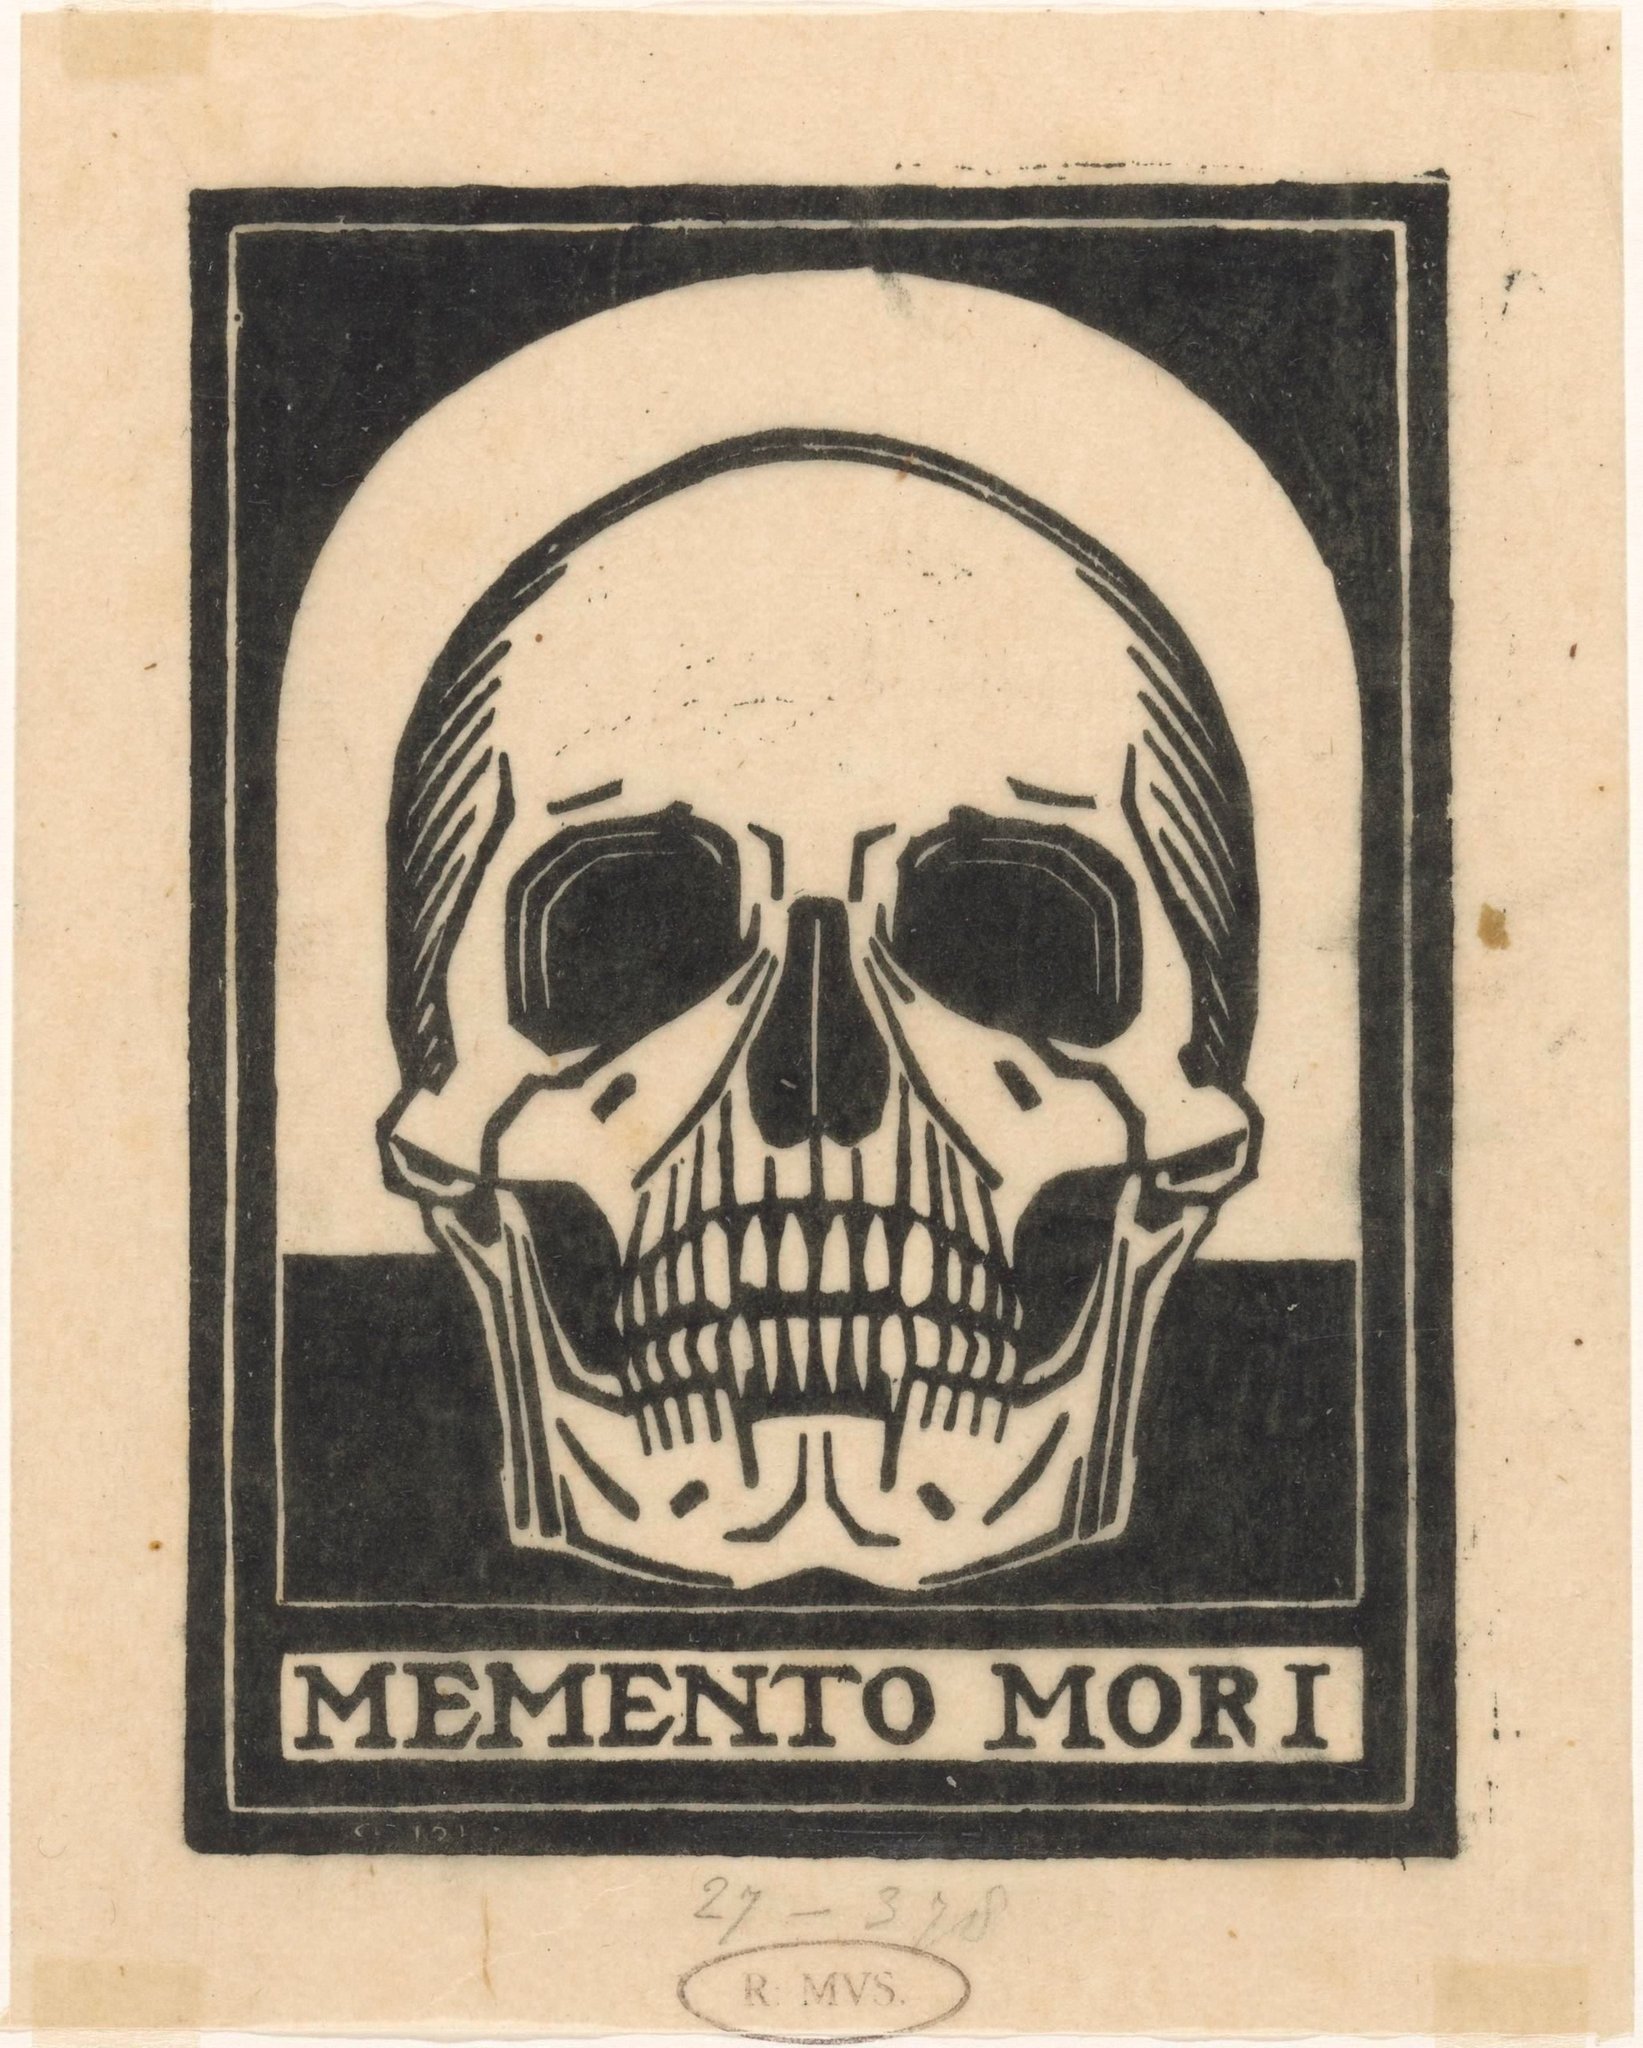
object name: print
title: Memento mori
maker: julie de graag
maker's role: draughtsman, print maker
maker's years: 1877-1924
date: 1916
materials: paper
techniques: woodcut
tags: death's head, skull (symbol of death)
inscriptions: collector's mark: Lugt 2228